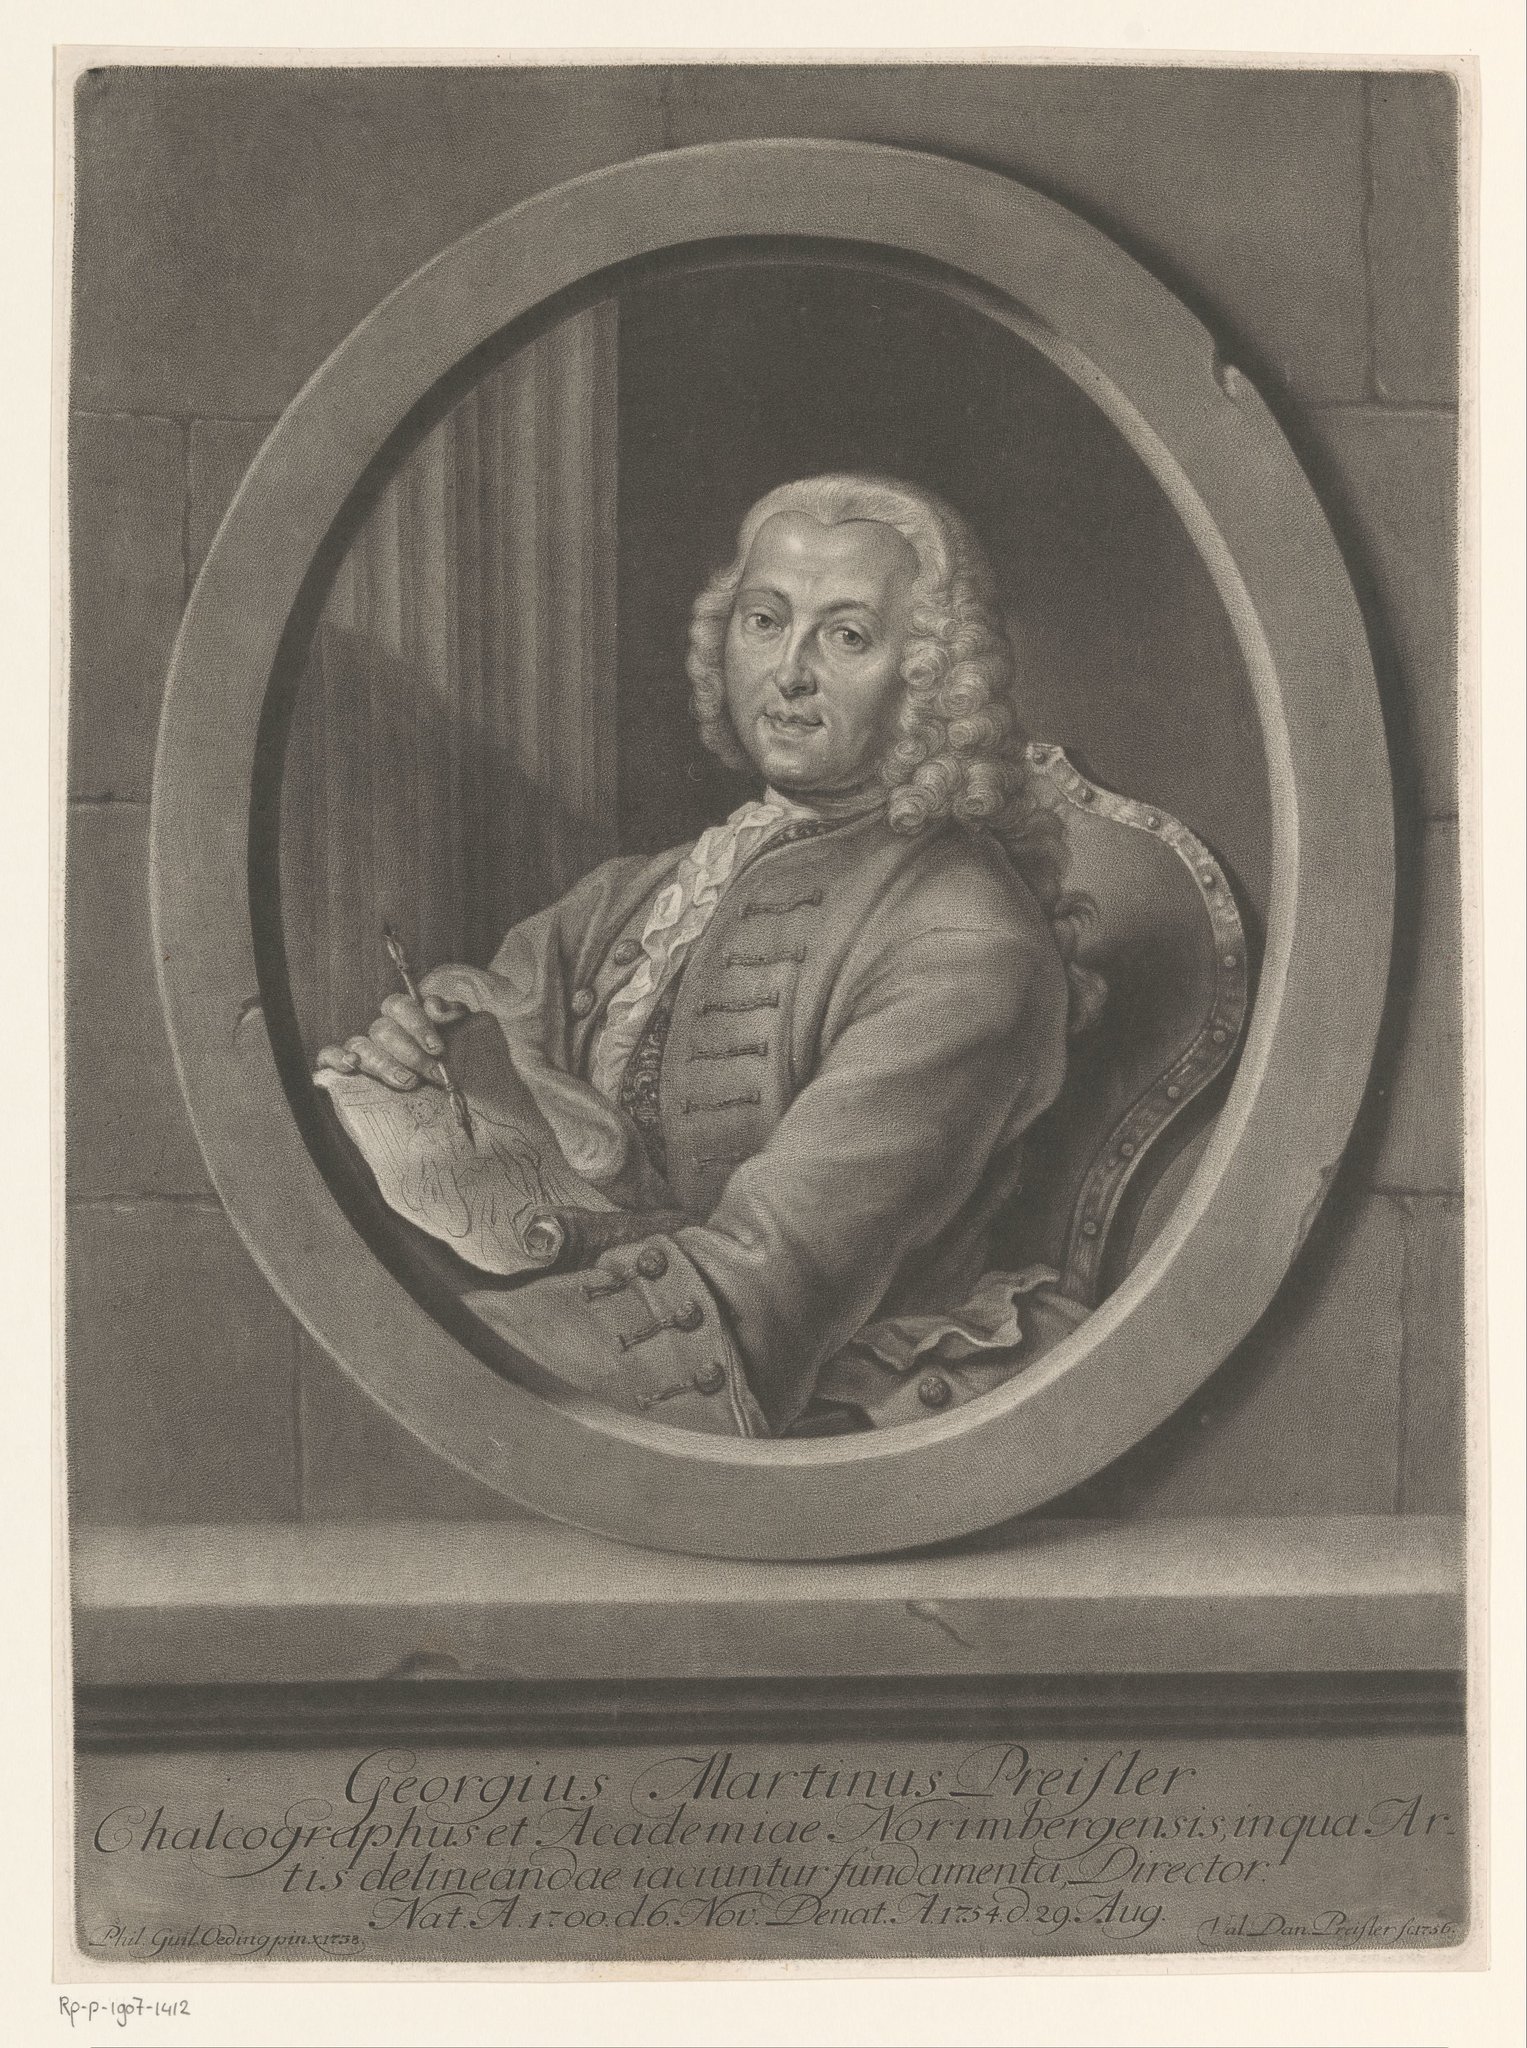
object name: print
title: Portret van Georg Martin Preissler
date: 1756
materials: paper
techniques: etching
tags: painter, print maker, historical persons, portrait, self-portrait of graphic artist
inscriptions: collector's mark: Lugt 2228